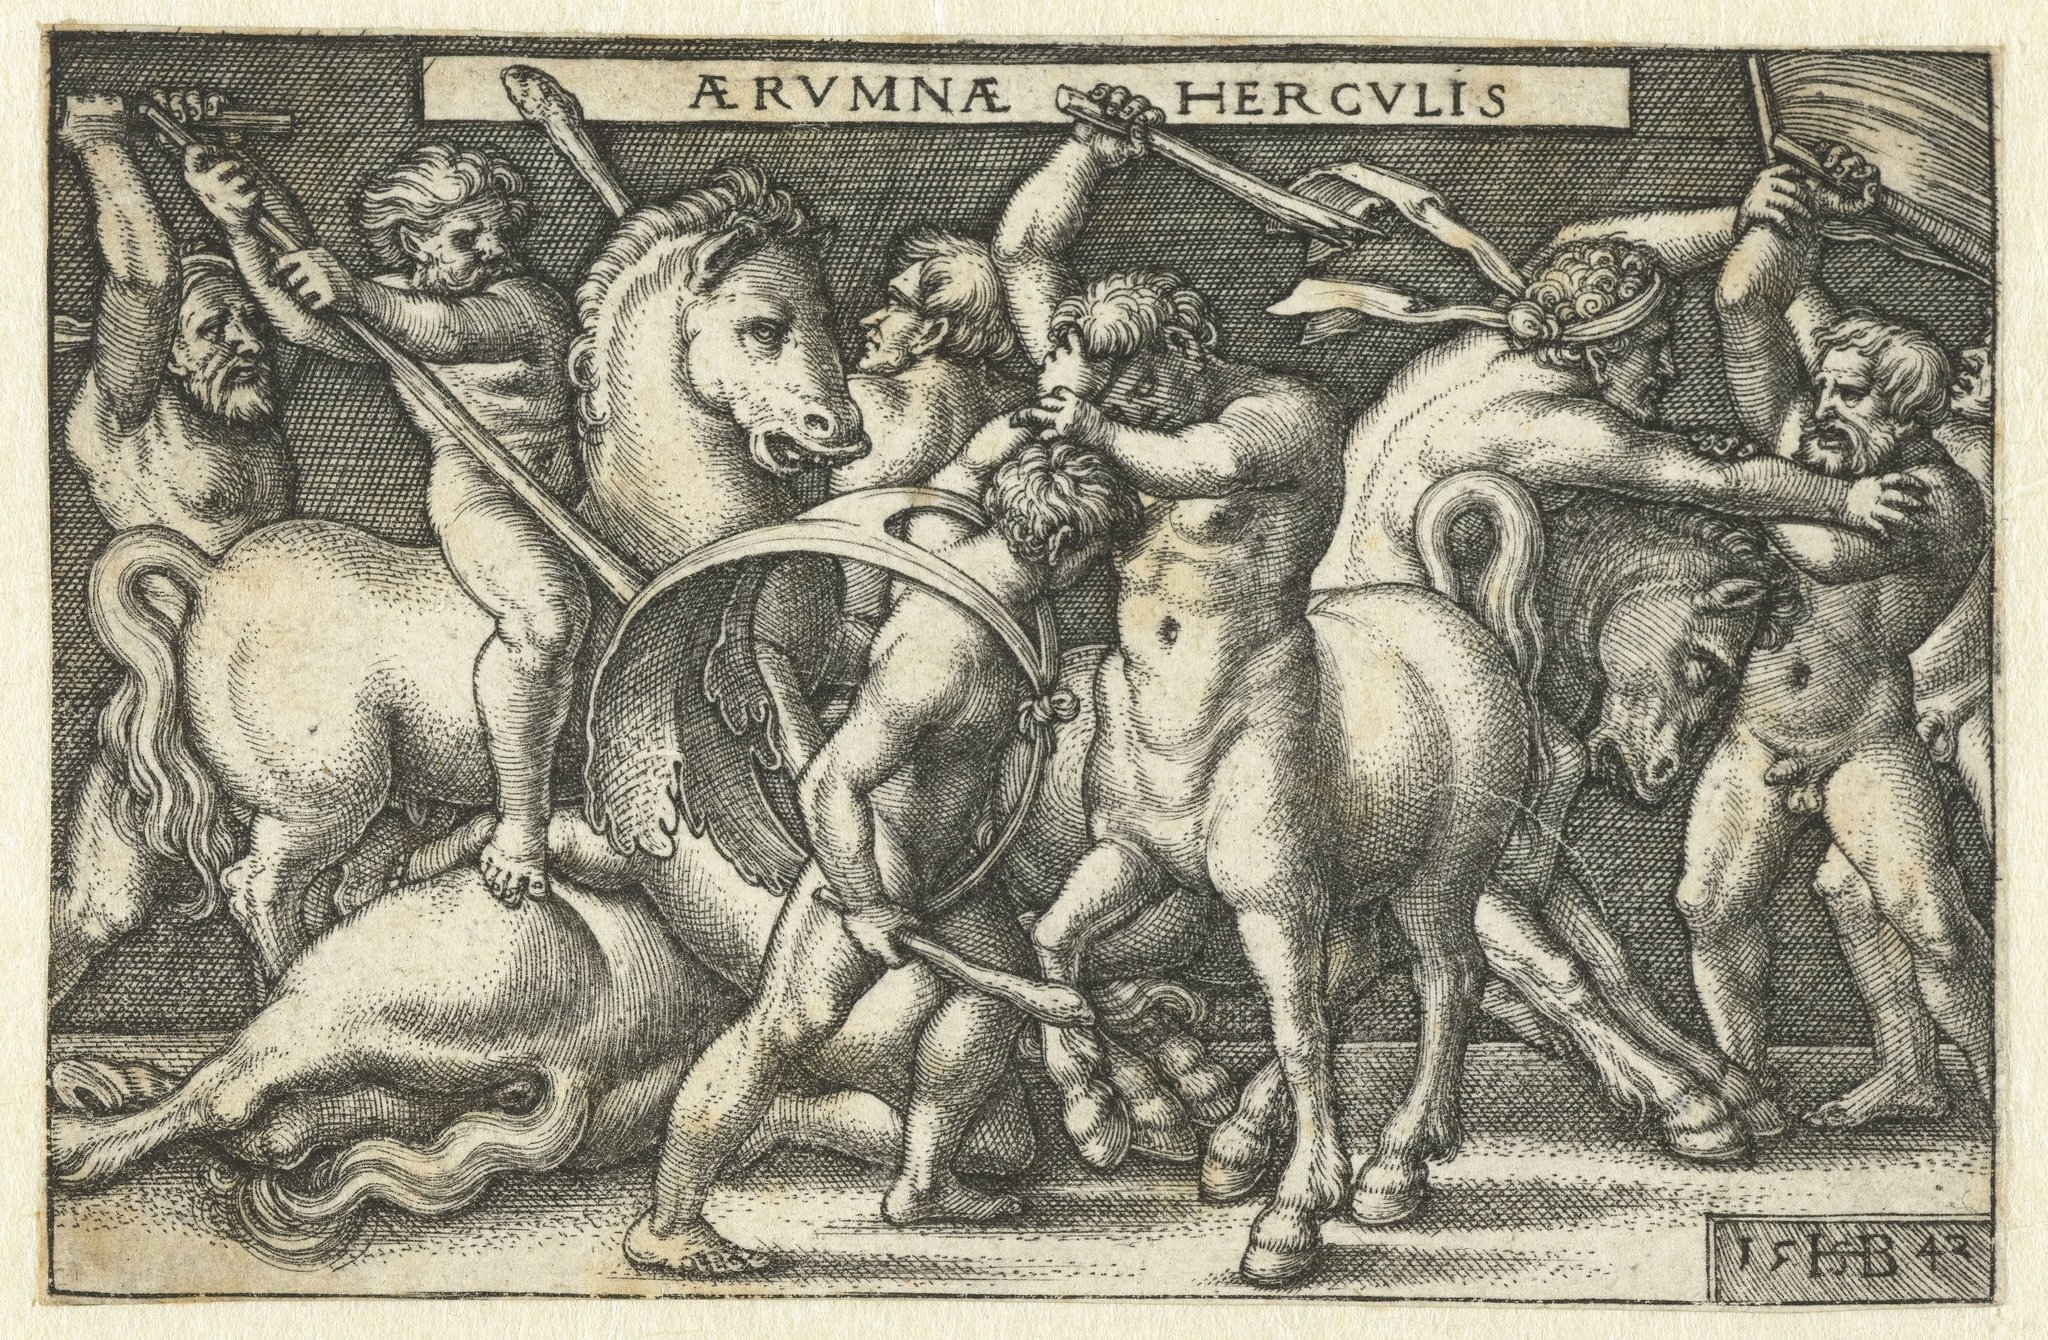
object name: print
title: Arvmnae Hercvlis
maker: hans sebald beham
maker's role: designer, draughtsman, print maker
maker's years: 1500-1550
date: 1542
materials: paper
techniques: engraving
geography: frankfurt am main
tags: most important deeds of hercules: the twelve labours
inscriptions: collector's mark: Lugt 2228a